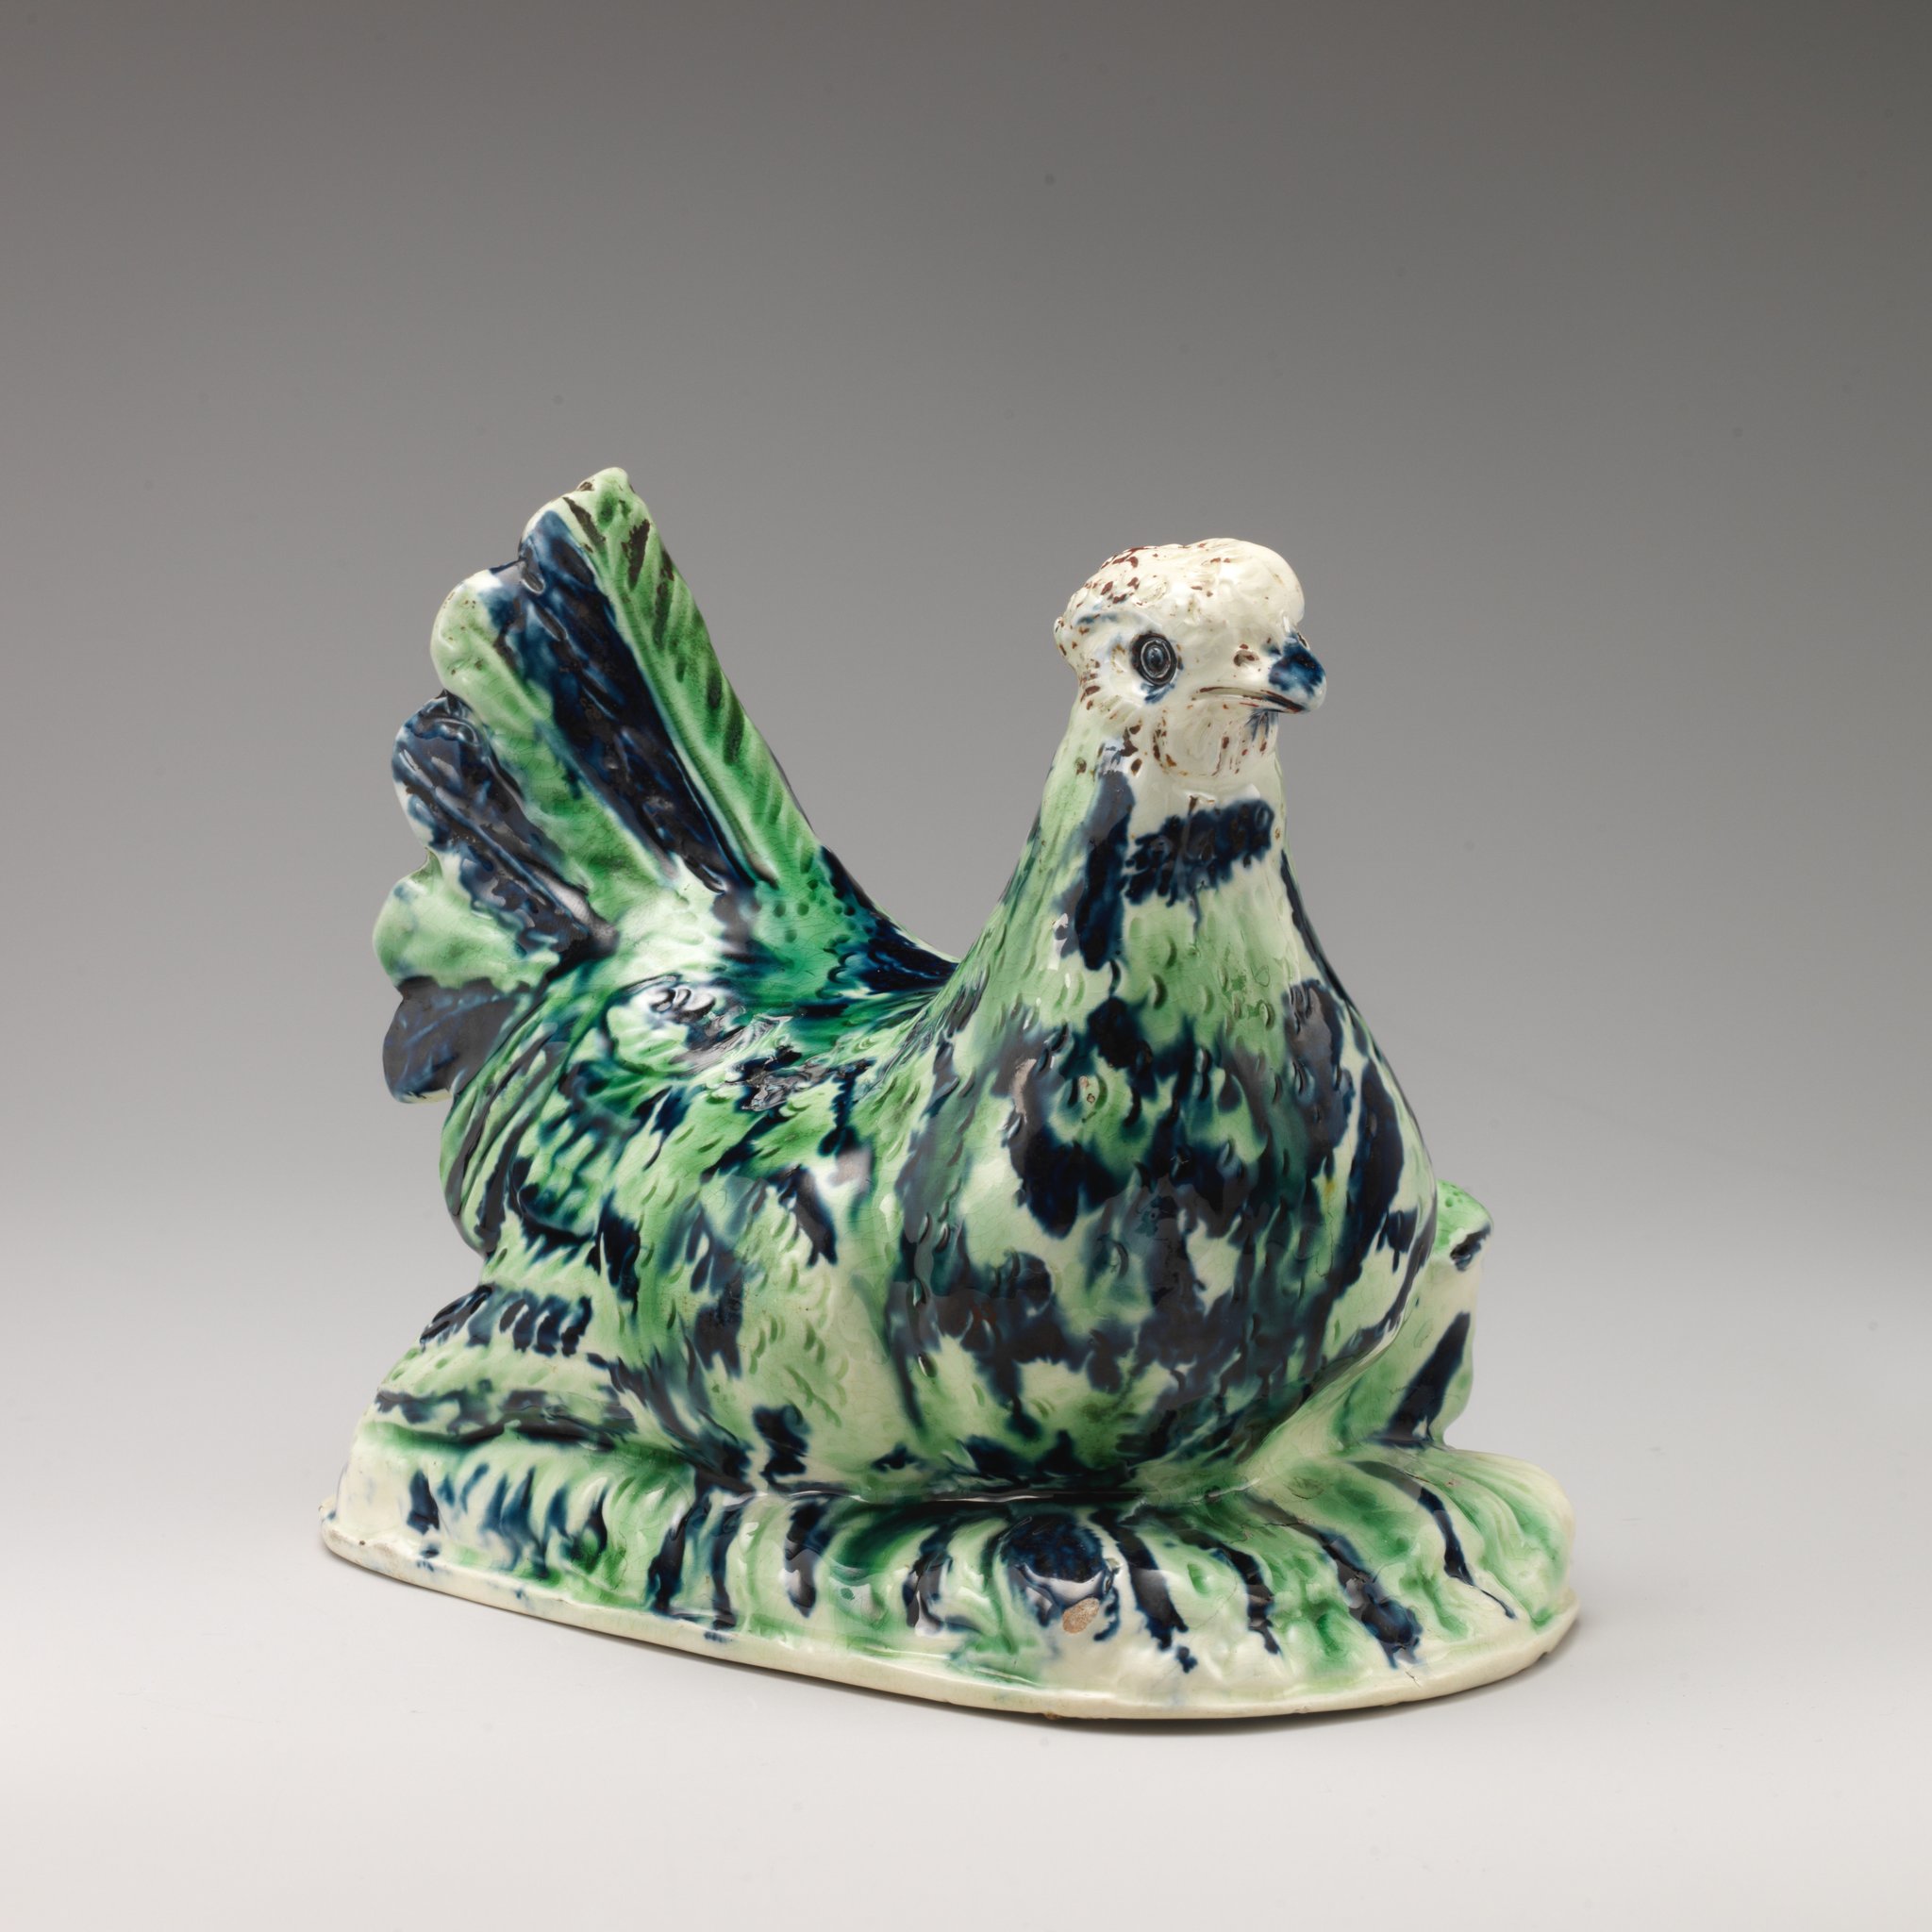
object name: figure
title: Hen with chicks (one of a pair)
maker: whieldon type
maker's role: maker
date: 1750-1760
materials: earthenware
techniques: glazing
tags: chickens